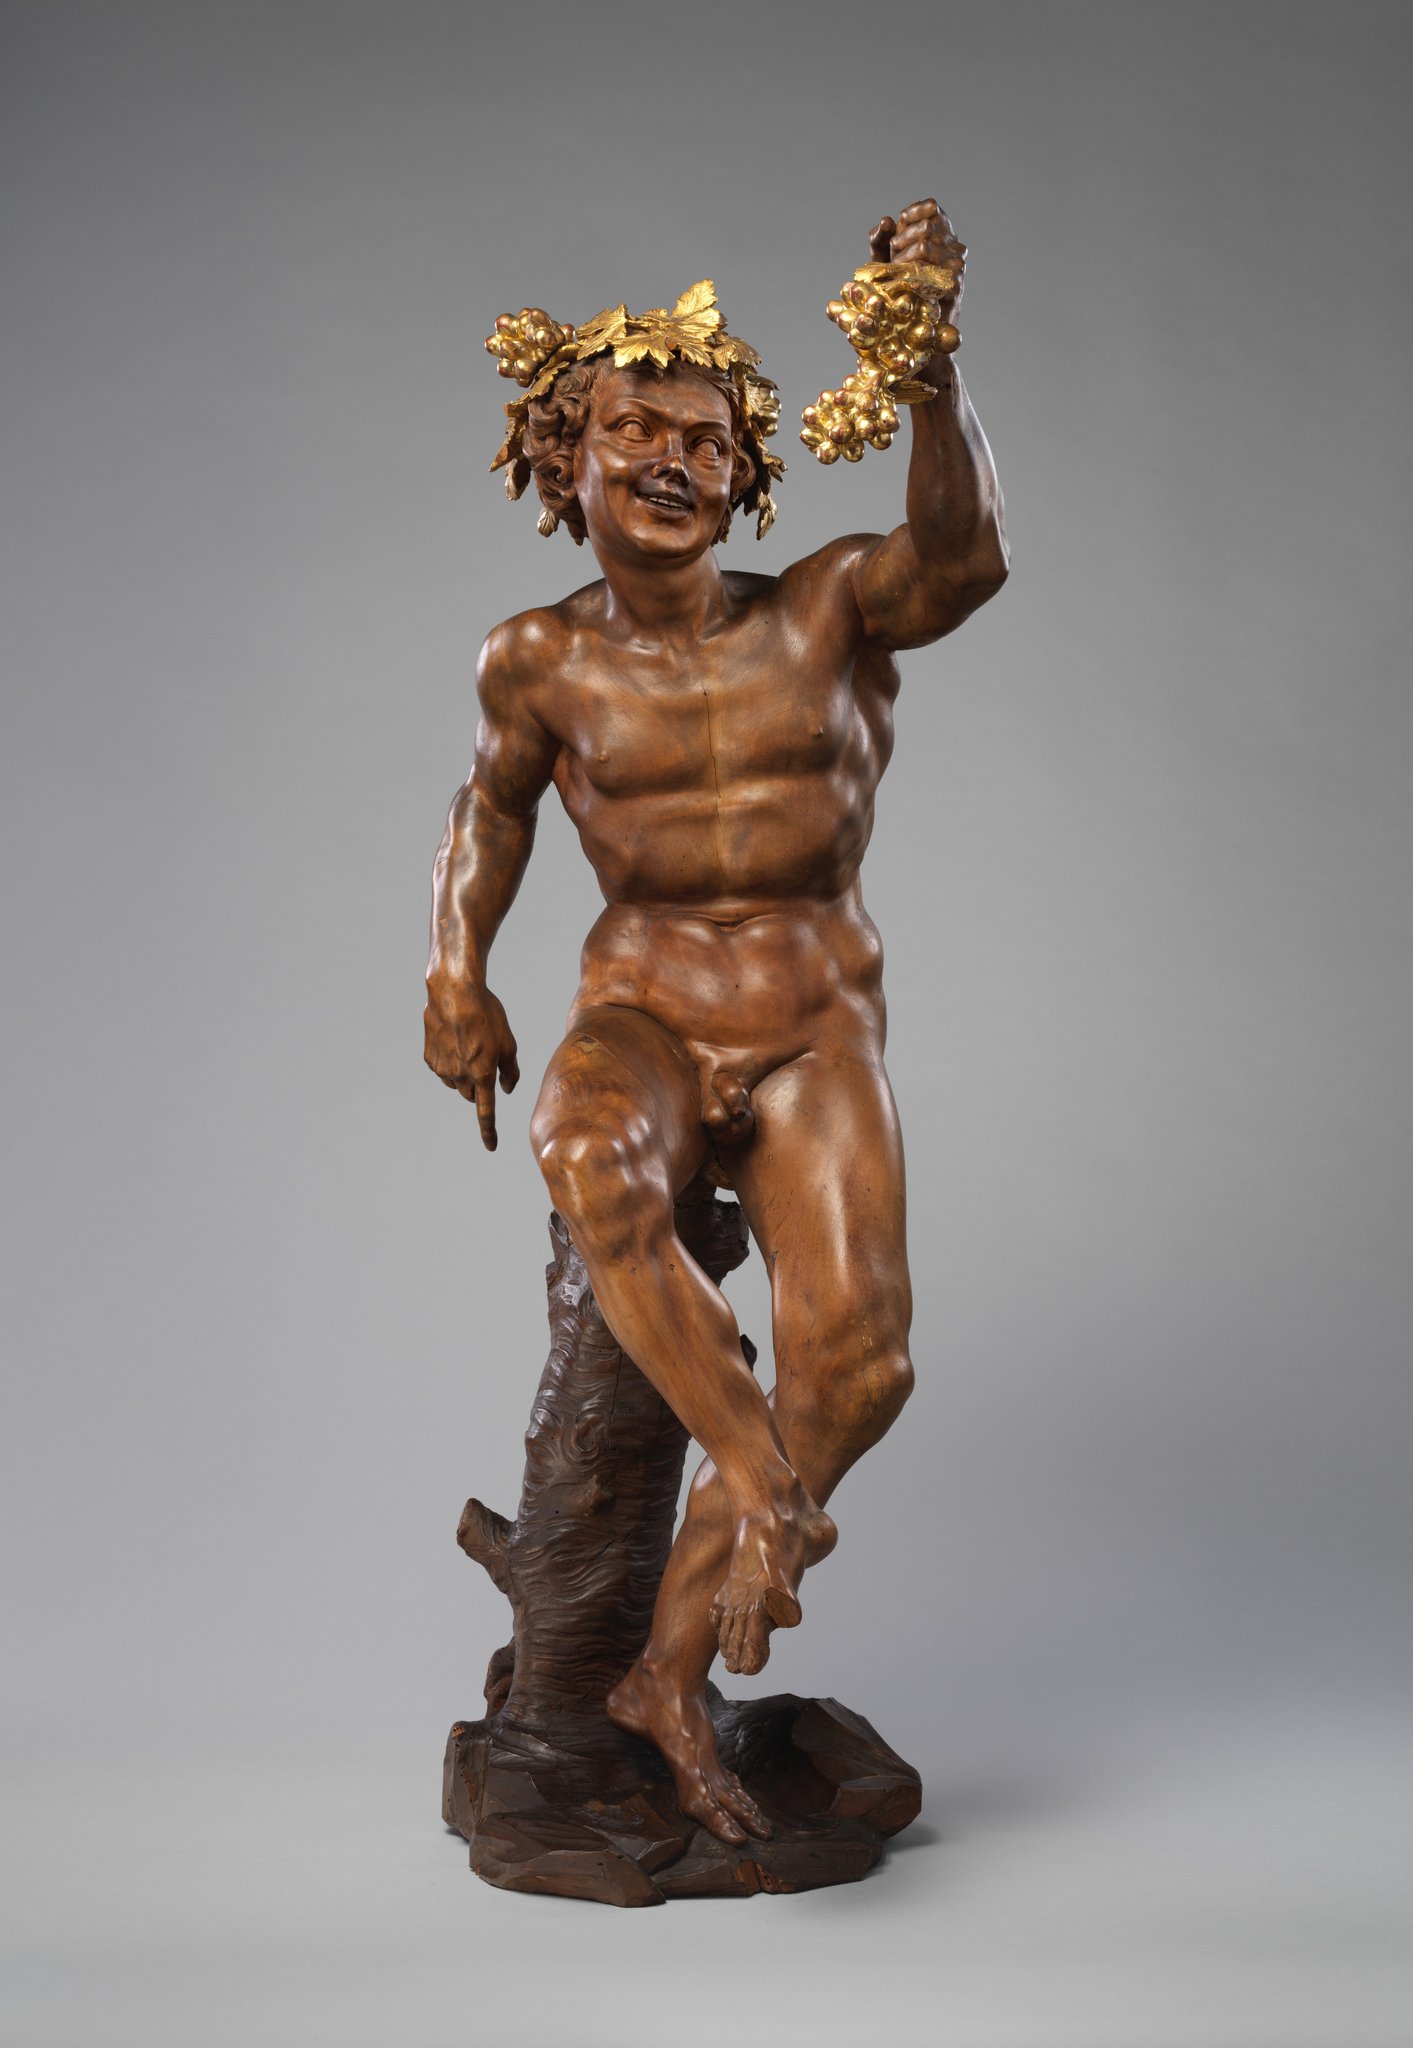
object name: figure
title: Allegory of Autumn (Bacchus)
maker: filippo parodi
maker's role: artist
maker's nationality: italian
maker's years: 1630-1702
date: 1670-1679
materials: gilt, wood, varnish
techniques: carving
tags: bacchus